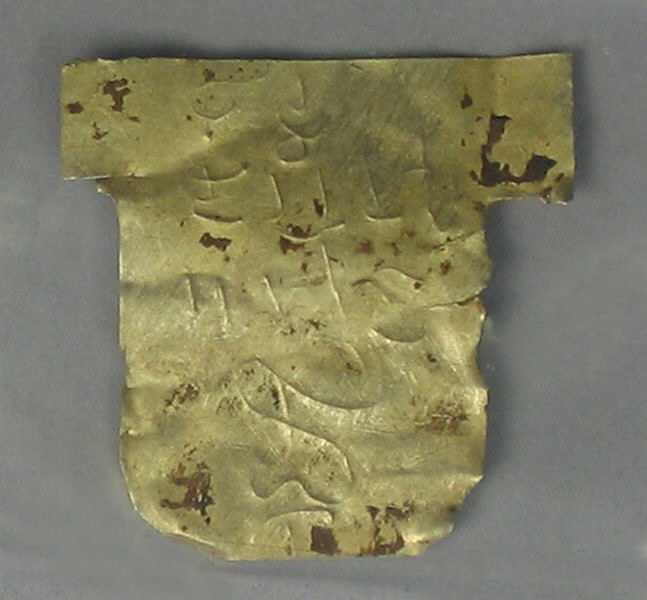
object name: foundation offering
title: One of Seven Foundation Offerings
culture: indonesian, central java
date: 701-1200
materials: gold